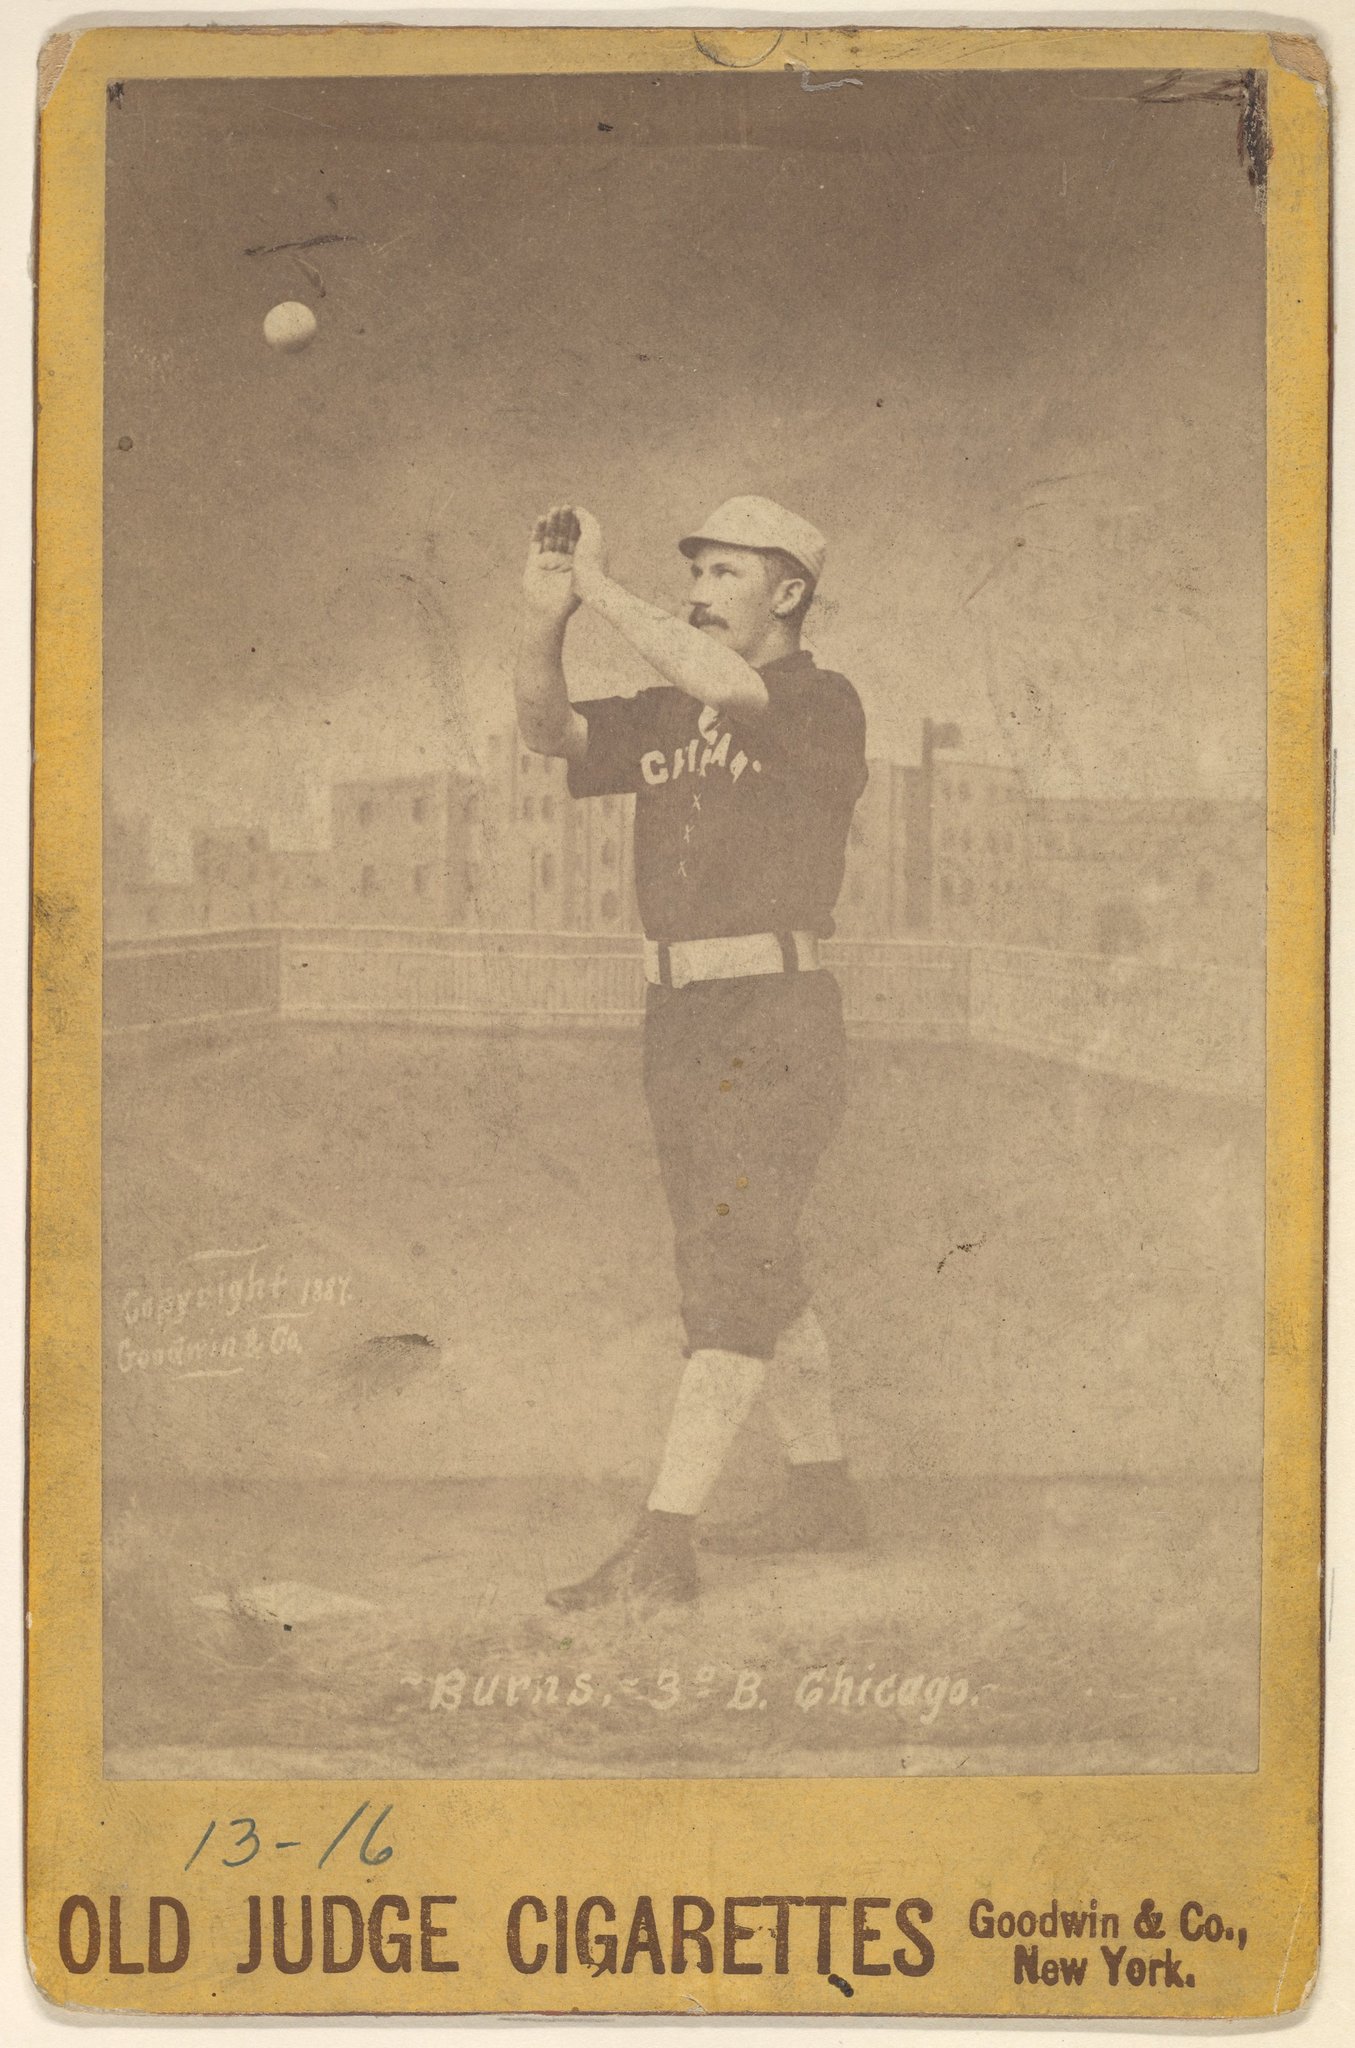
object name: baseball card, photograph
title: Burns, 3rd Base, Chicago, from the series Old Judge Cigarettes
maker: goodwin & company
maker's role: publisher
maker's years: 1850-1950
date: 1887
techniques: albumen silver print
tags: men,portraits,baseball,athletes